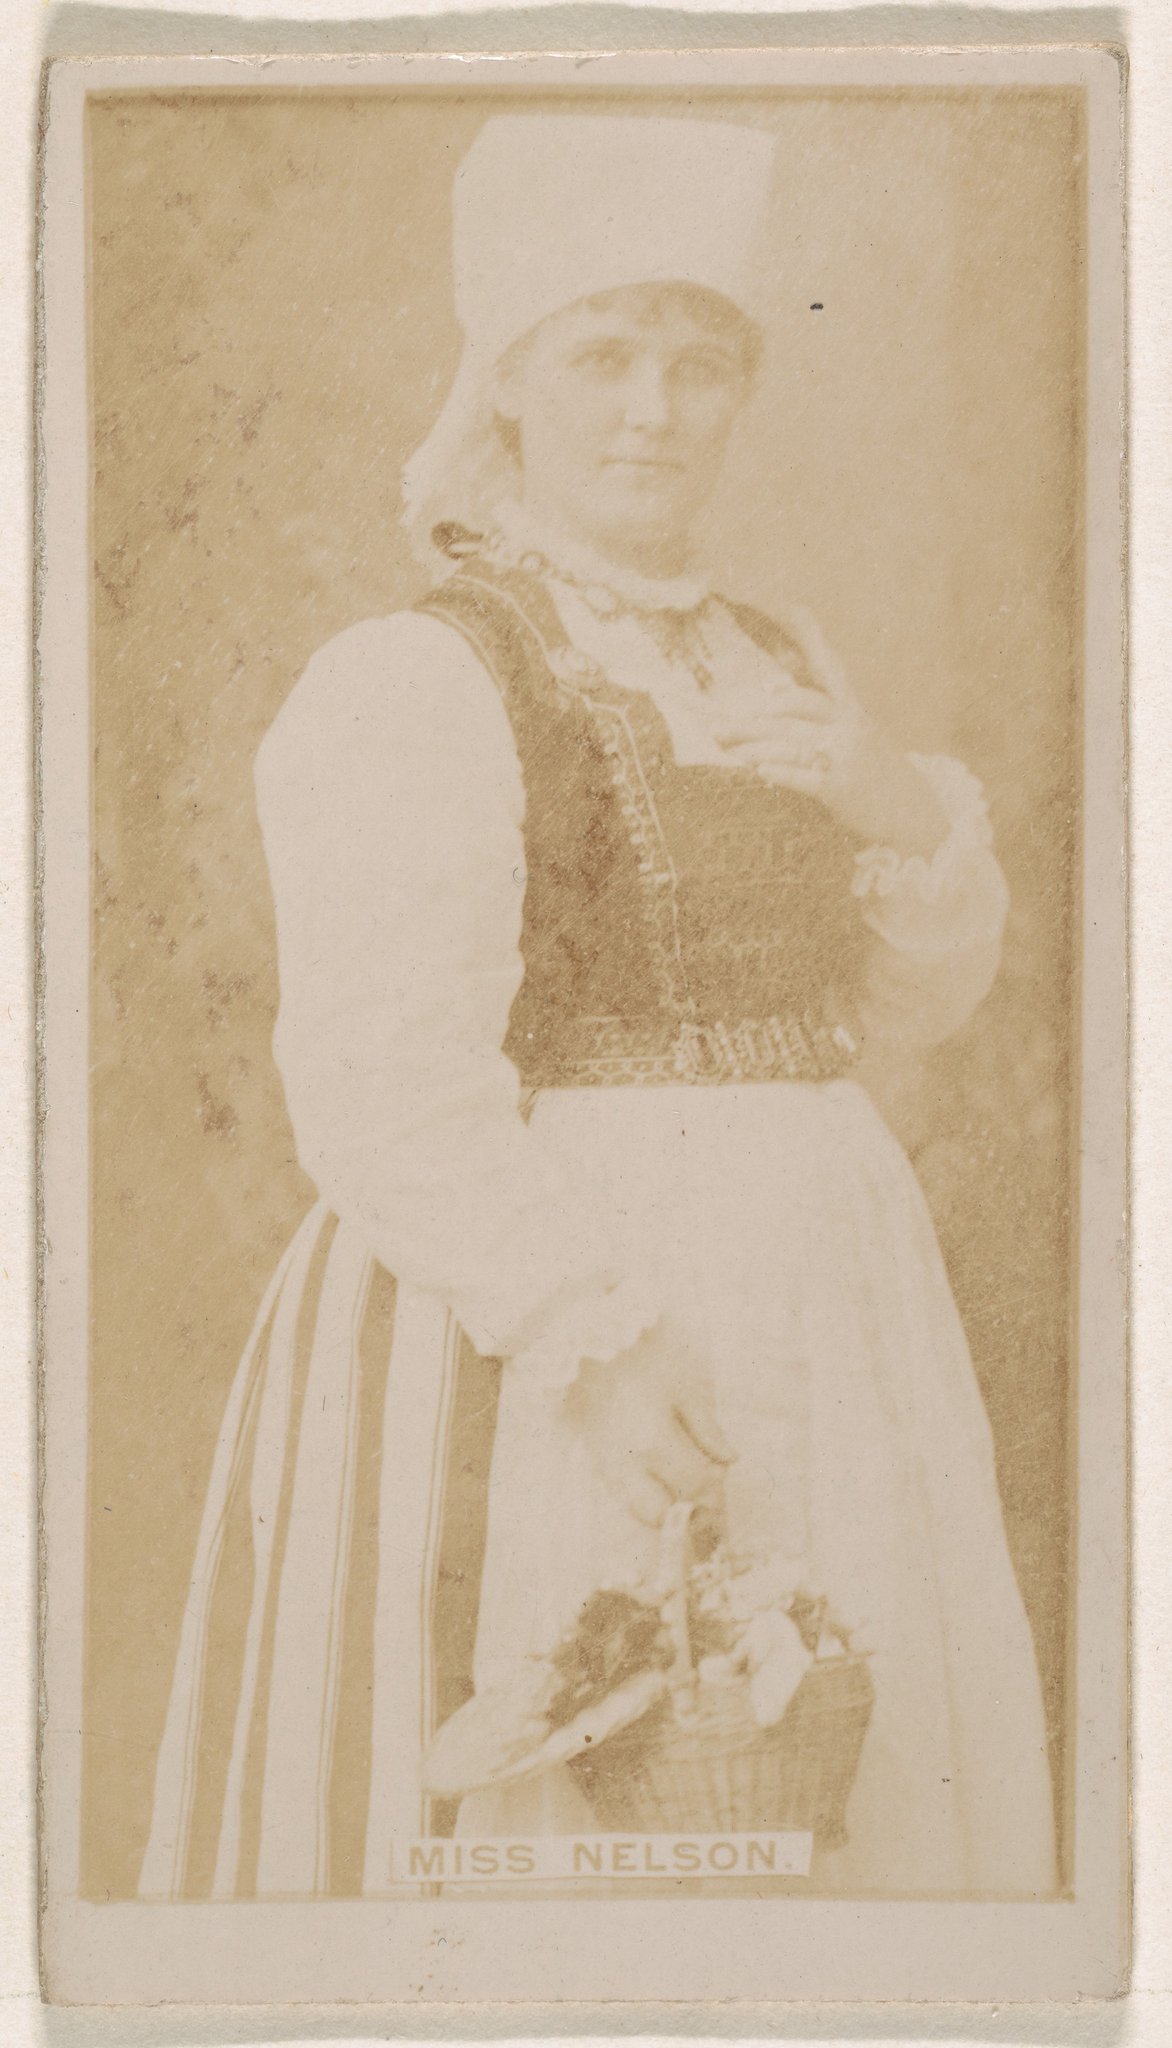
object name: photograph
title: Miss Nelson, from the Actresses series (N245) issued by Kinney Brothers to promote Sweet Caporal Cigarettes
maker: kinney brothers tobacco company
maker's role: publisher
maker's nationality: american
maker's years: 1869-2011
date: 1890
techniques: albumen silver print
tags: portraits,women,actresses